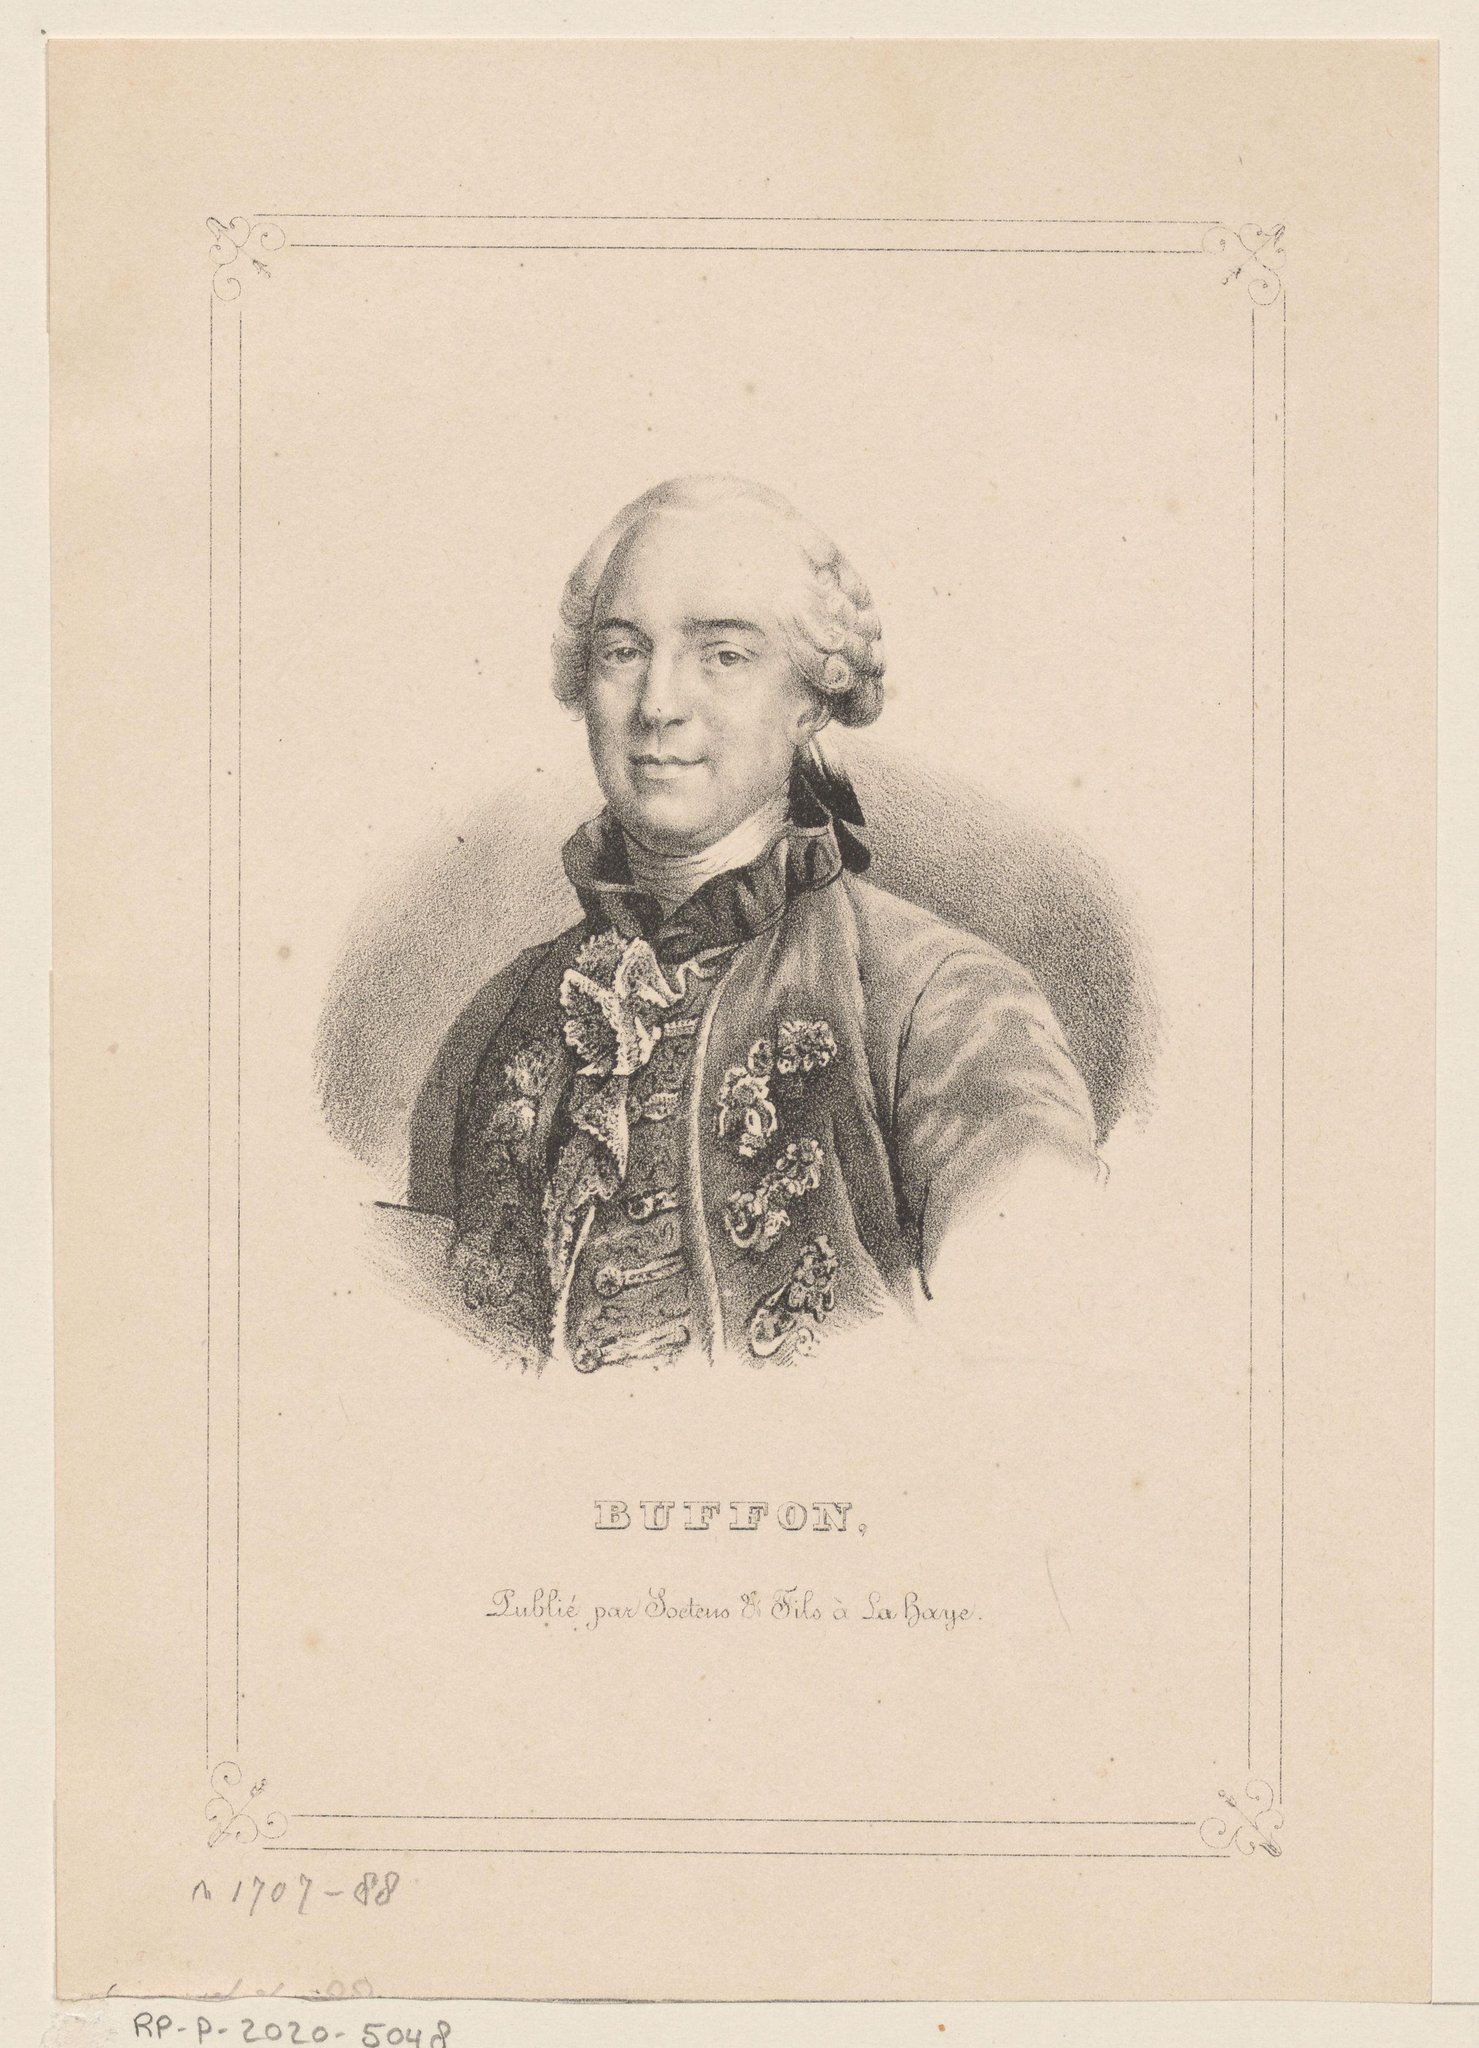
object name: print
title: Portret van Georges-Louis Leclerc de Buffon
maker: Anonymous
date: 1837-1840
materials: paper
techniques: lithograph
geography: the hague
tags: paris, georges-louis leclerc de buffon (graaf), scholar, philosopher, historical persons